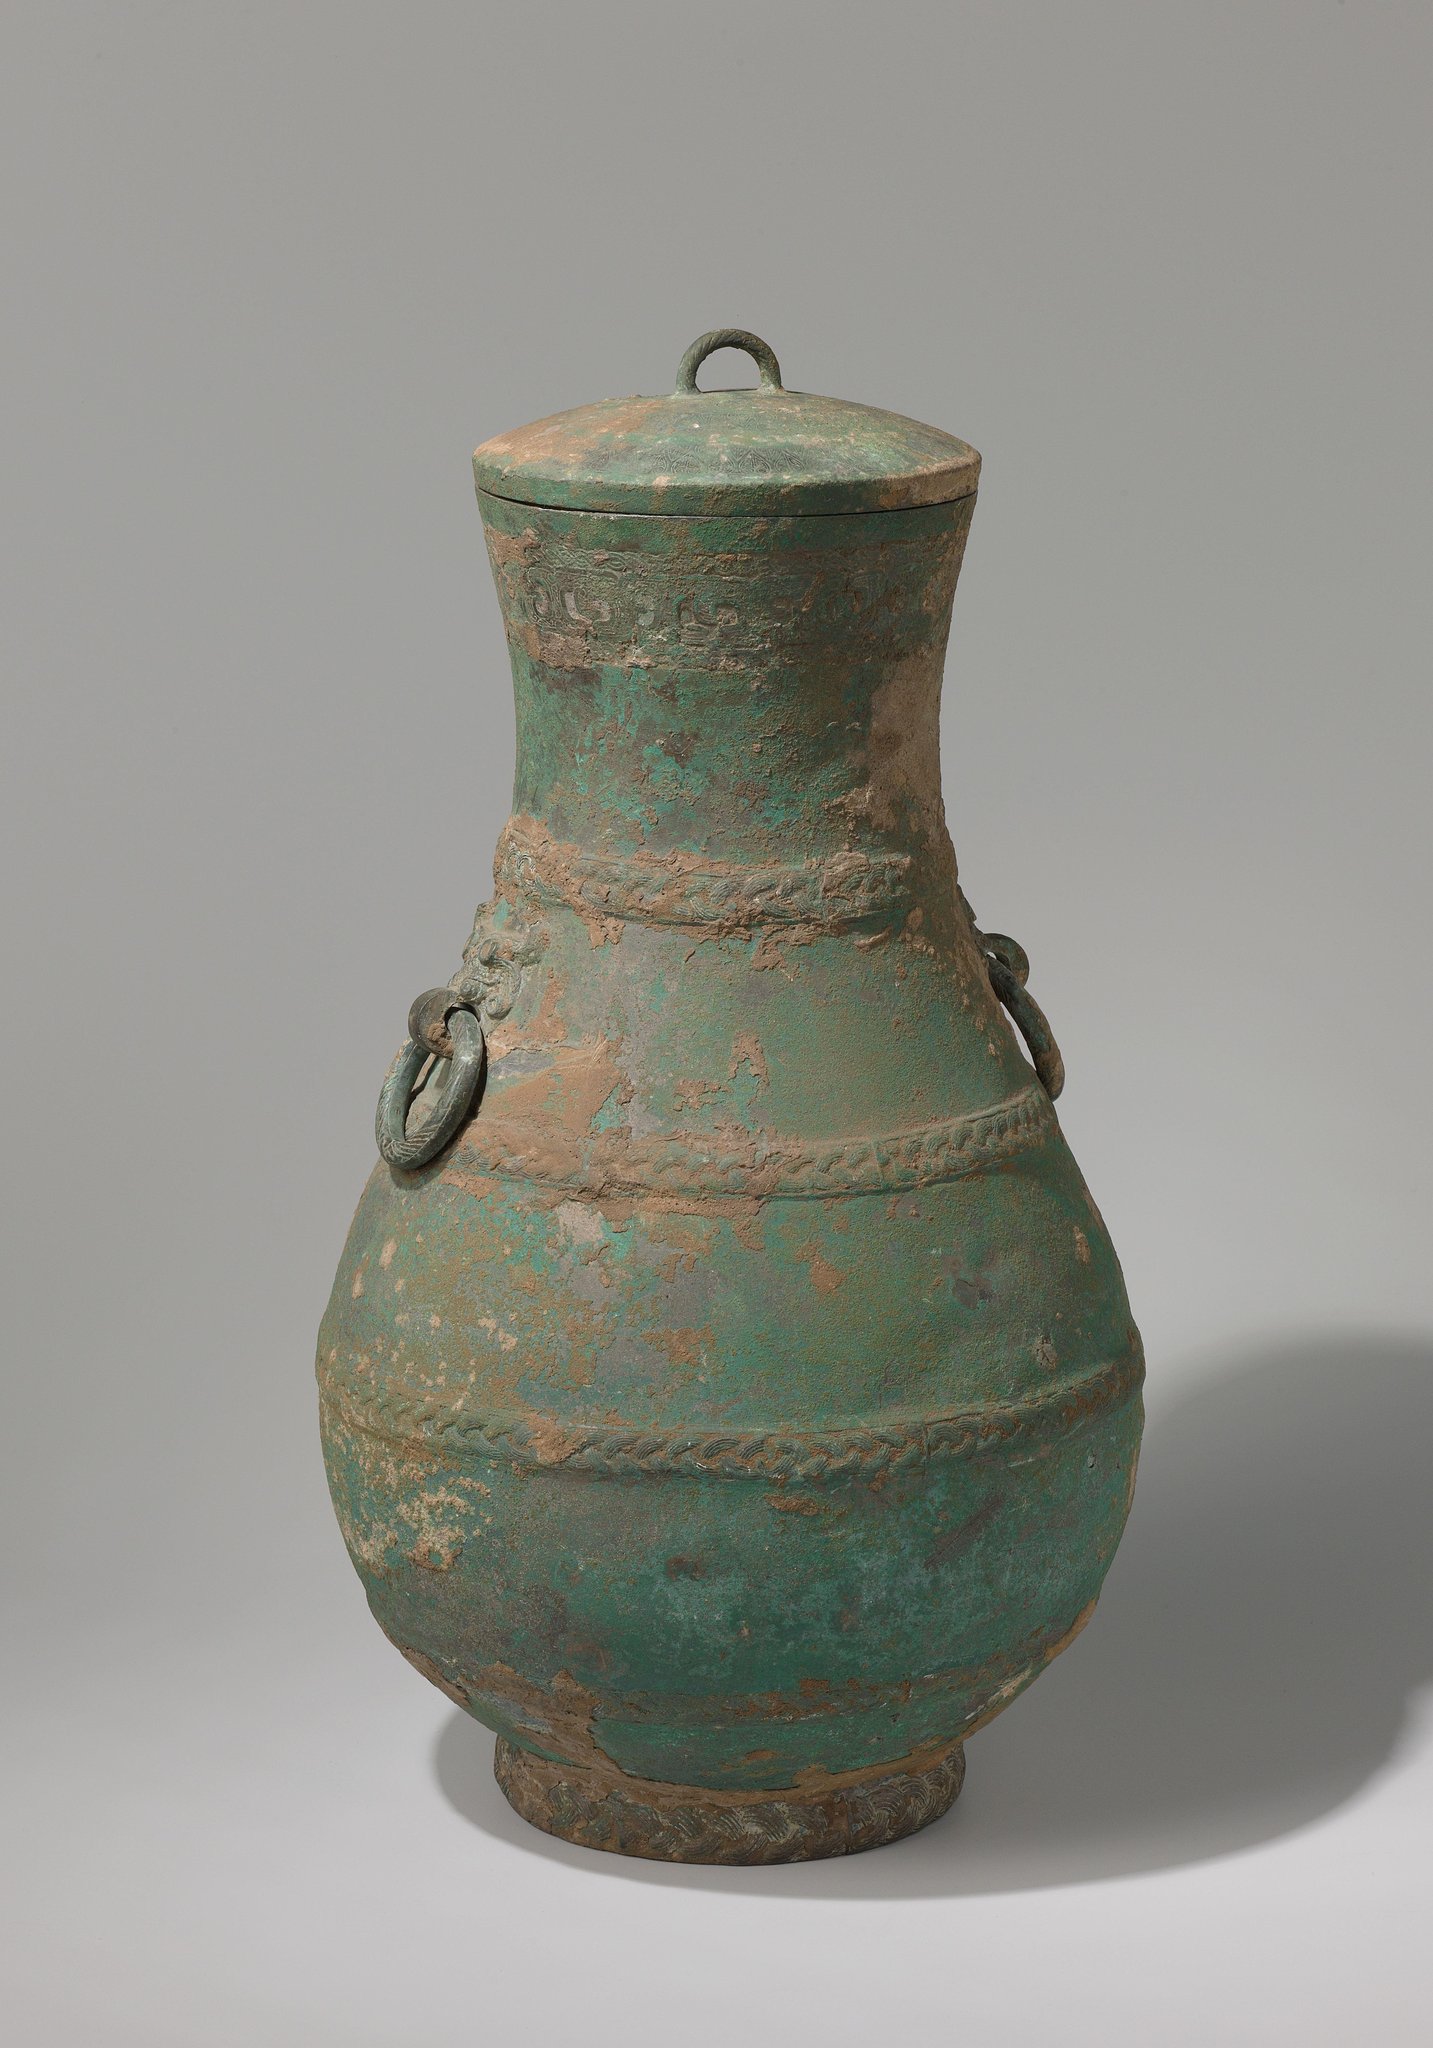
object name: wine cup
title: Rituele wijnbeker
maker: Anonymous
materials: bronze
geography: china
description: Rituele wijnbeker met vijf banden van vlechtwerk om het vat, waarvan één om de voet.